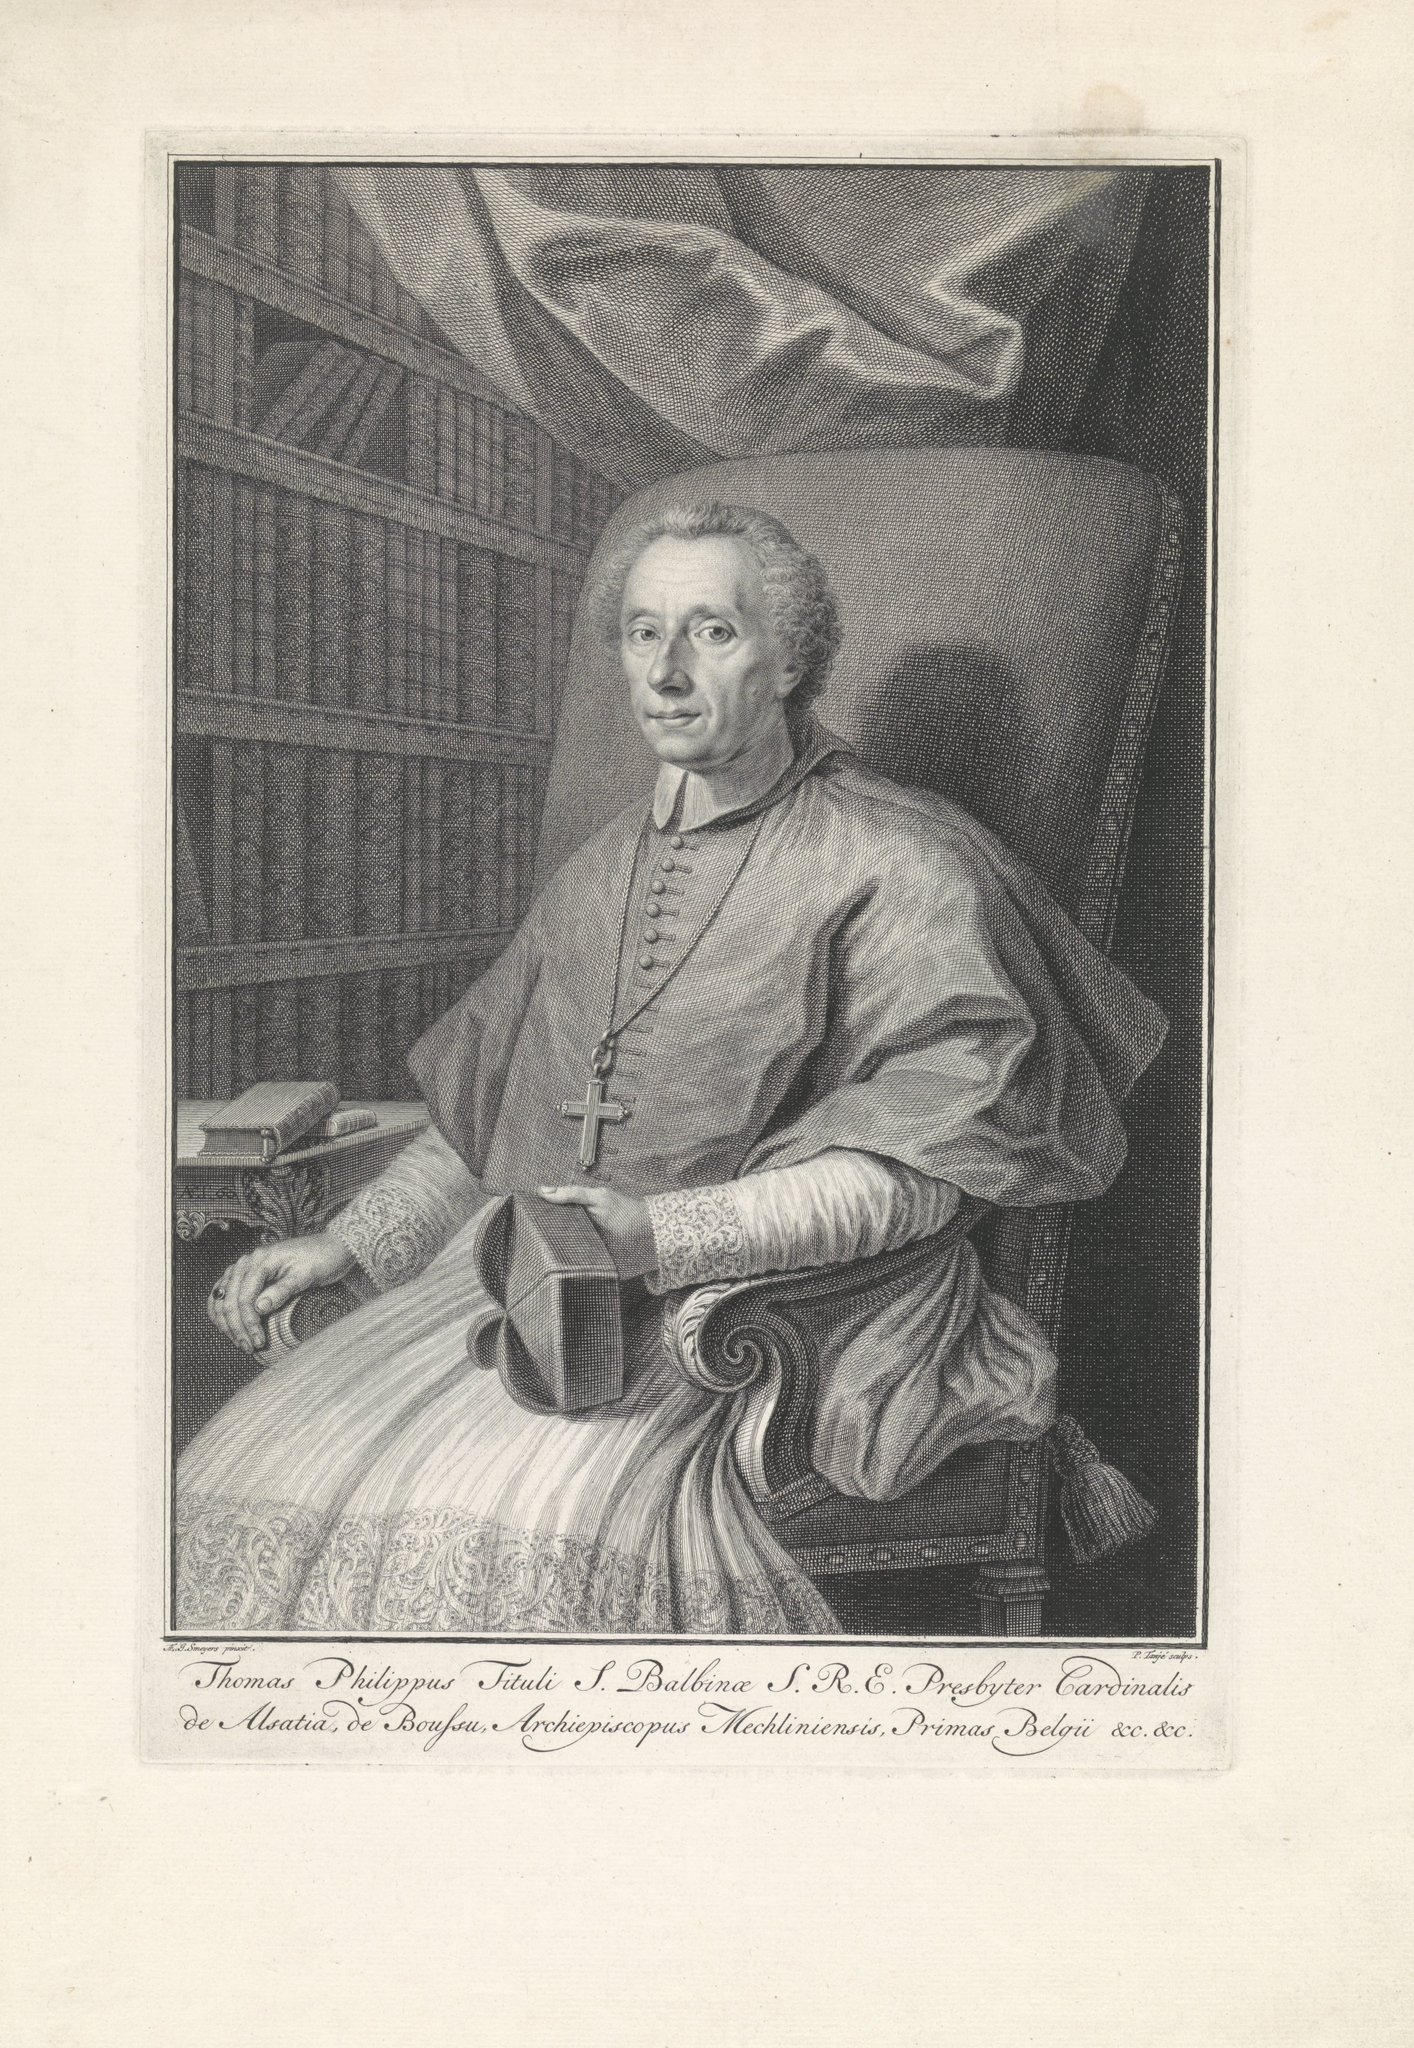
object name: print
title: Portret van Thomas-Philippus D'Alsace et du Boussu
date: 1716-1761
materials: paper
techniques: engraving, etching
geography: amsterdam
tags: mechelen, book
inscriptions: collector's mark: Lugt 2228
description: Thomas-Philippus D'Alsace et du Boussu, aartsbisschop van Mechelen, zit in een stoel met zijn baret in de hand. Op de achtergrond een boekenkast.